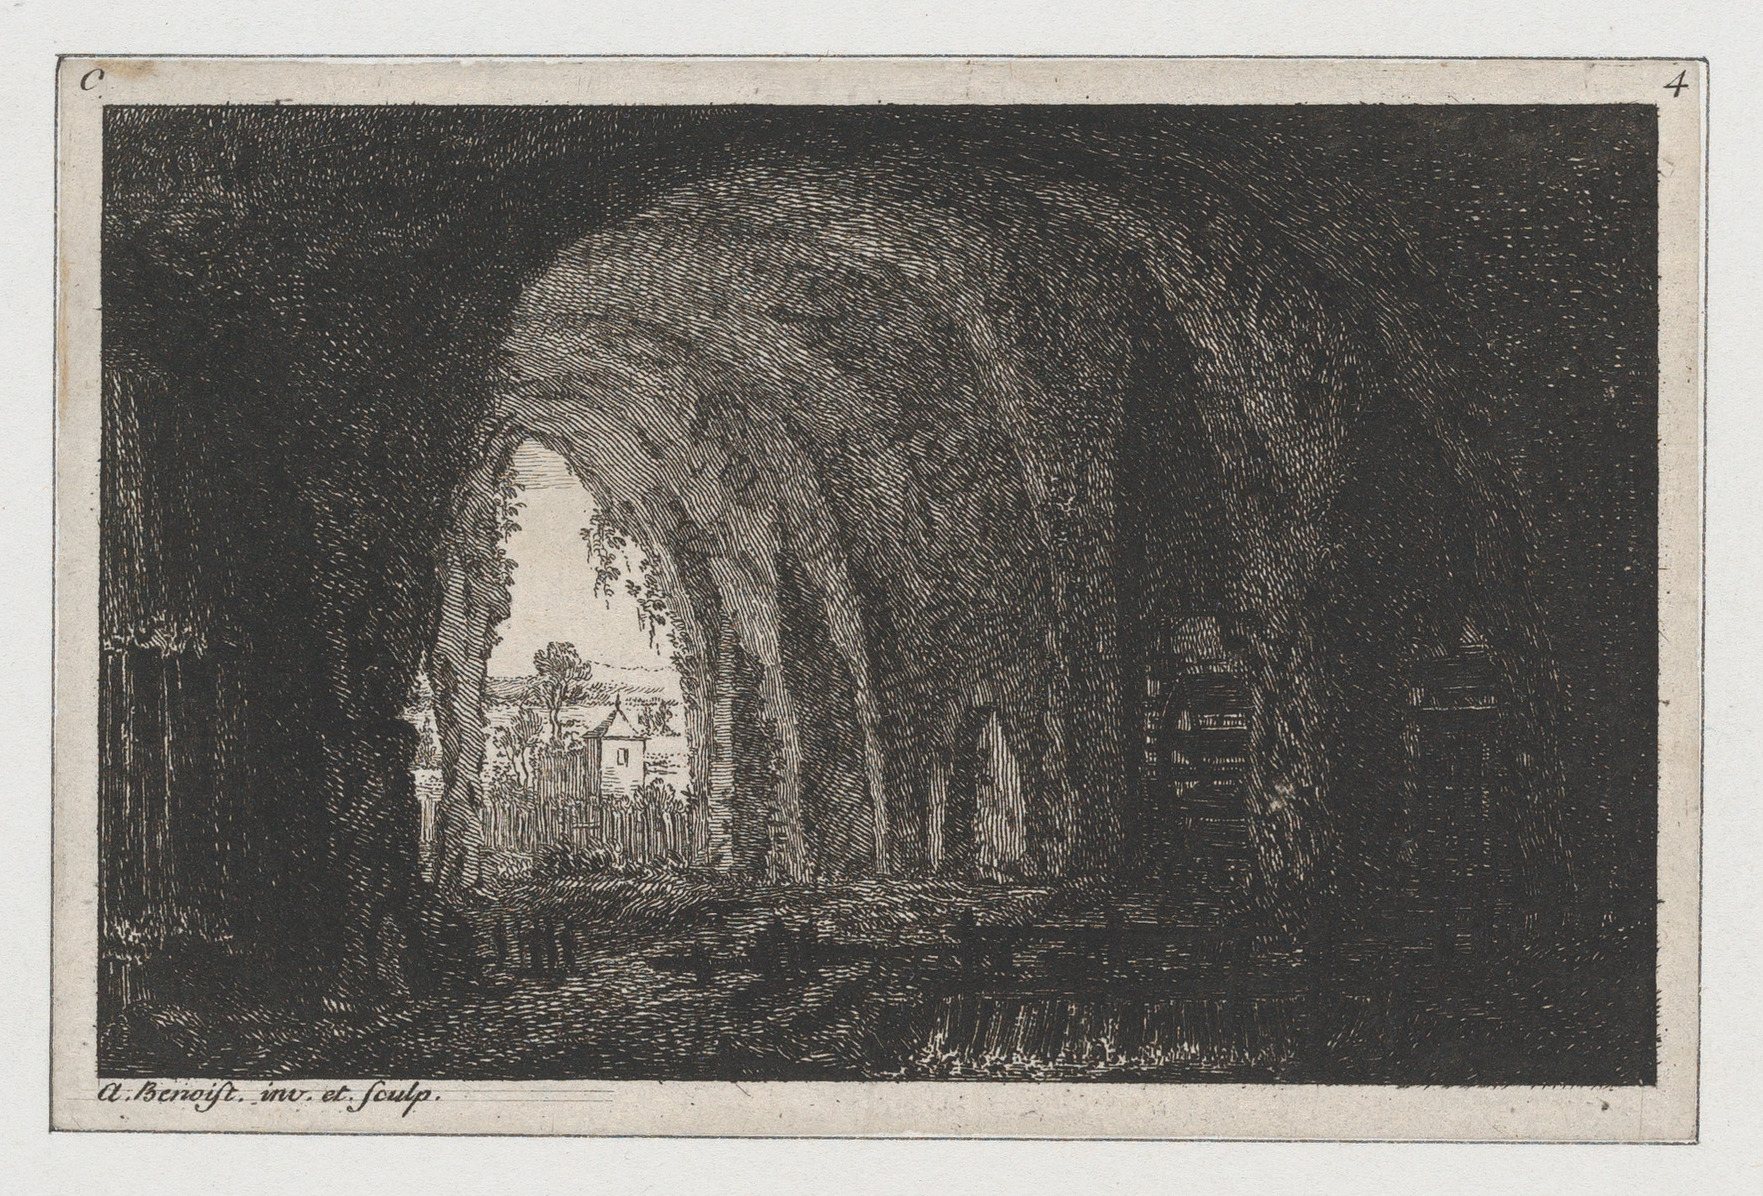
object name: print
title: Interior of a Cave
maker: antoine benoist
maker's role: artist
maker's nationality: french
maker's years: 1721-1770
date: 1741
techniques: engraving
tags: caves